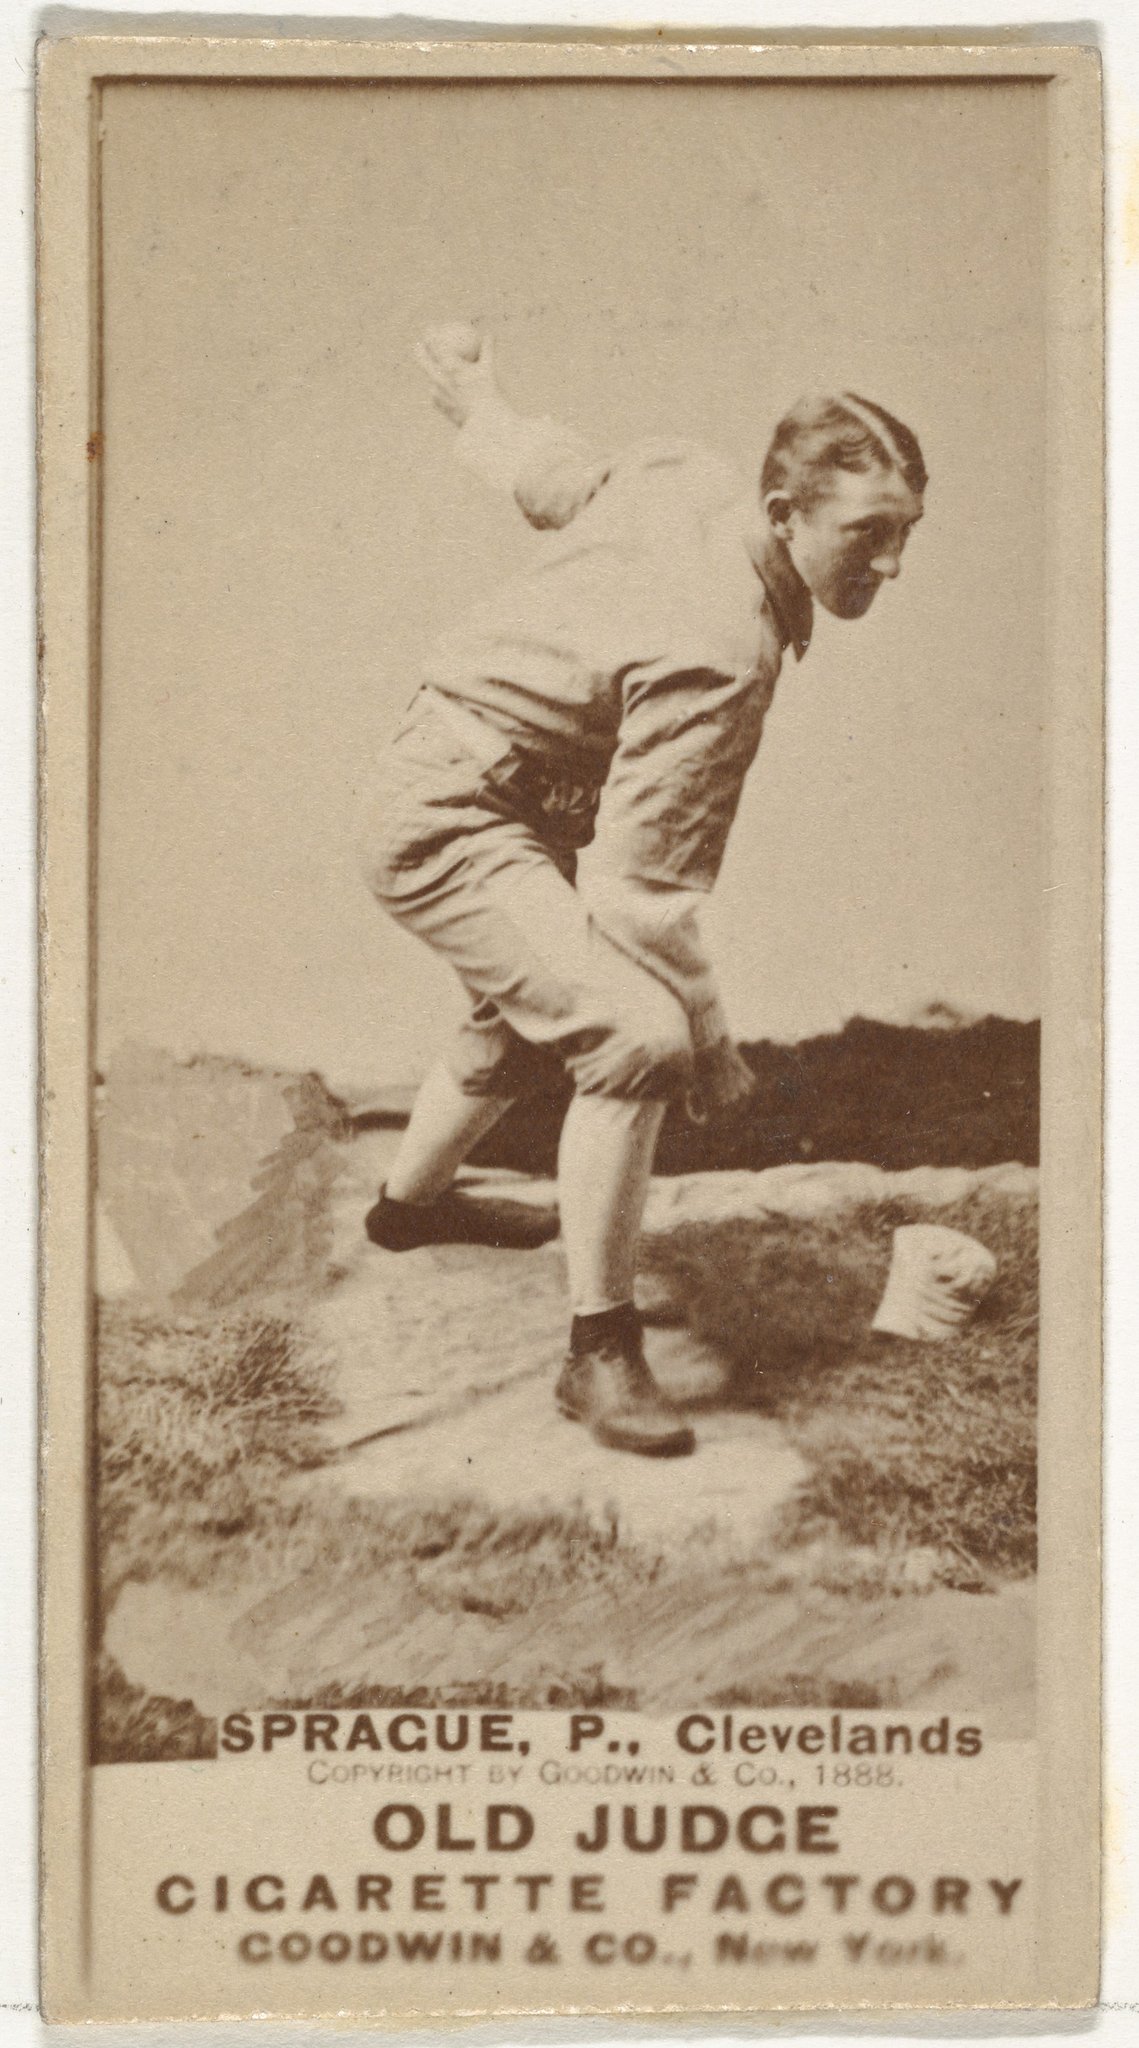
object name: baseball card, photograph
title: Charlie Sprague, Pitcher, Cleveland, from the Old Judge series (N172) for Old Judge Cigarettes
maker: goodwin & company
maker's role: publisher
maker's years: 1850-1950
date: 1888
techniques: albumen silver print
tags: men,portraits,baseball,athletes